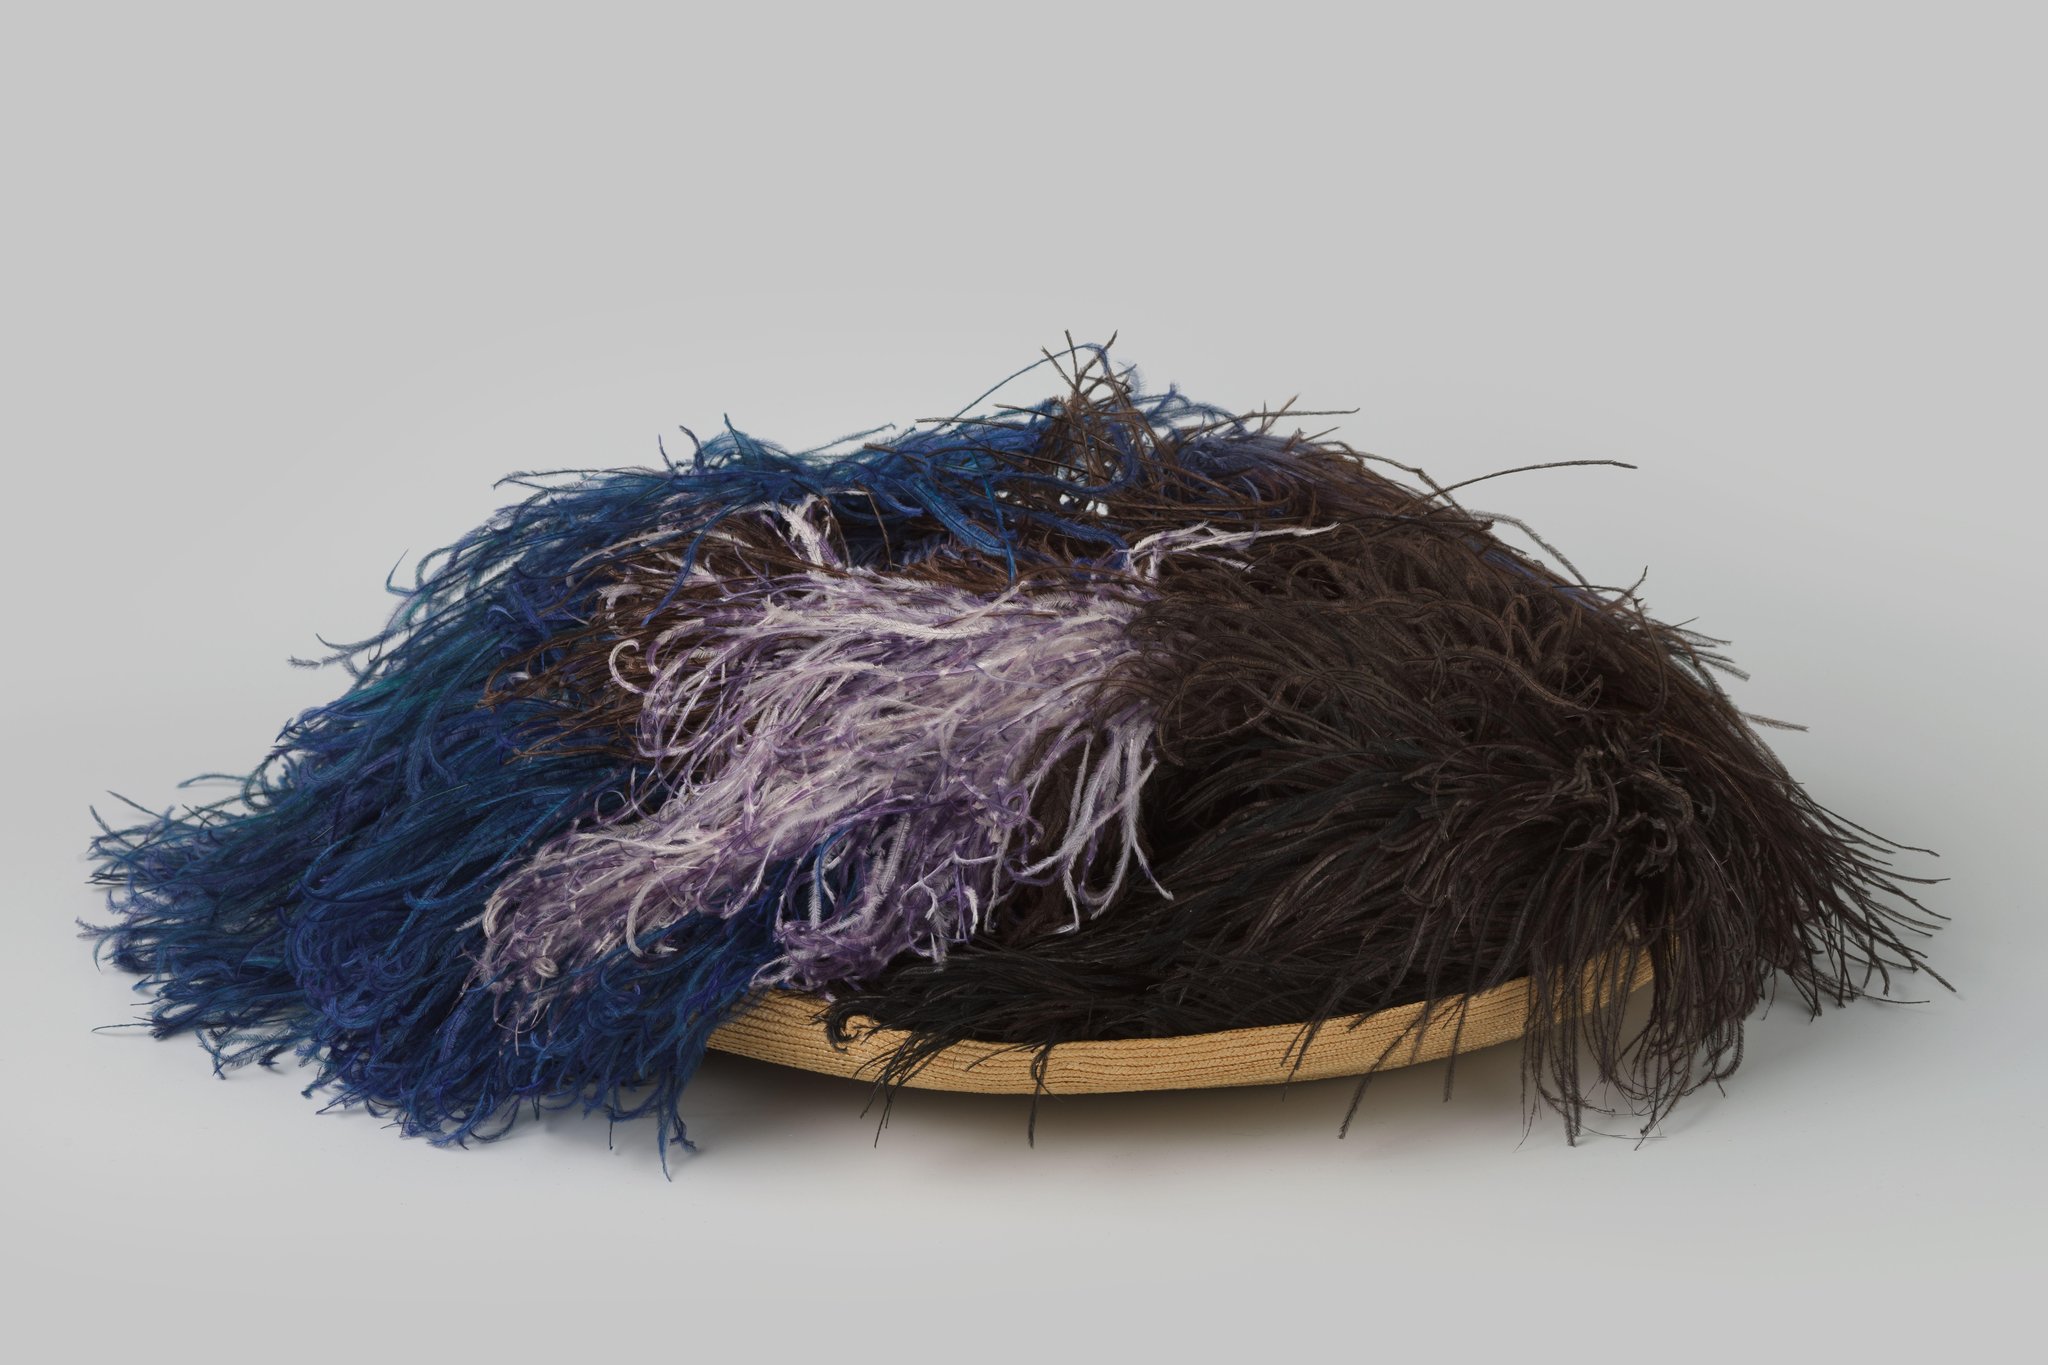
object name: hat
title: Hoed van stro met bruine, lila, blauw-groene en zwarte pleureuses, struisveren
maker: Anonymous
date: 1905-1915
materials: straw, ostrich feather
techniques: strohalm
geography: paris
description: Hoed van fijn, maar ruig, stro. Donkerbruine, lila, blauw-groene en zwarte pleureuses, struisveren. Zwarte voile met grote openingen en gevuld met blokjes. Platte, ronde bol met brede rand, die iets opwipt om de pleureuses te dragen. Geel hoedenlint geheel, en de hoedenbol, gedeeltelijk onzichtbaar onder de lila, bruine en blauwe veren, die over de rand afhangen. Zwarte veer rust van voren van binnen tegen de rand, waar de halve voile onderuit hangt.